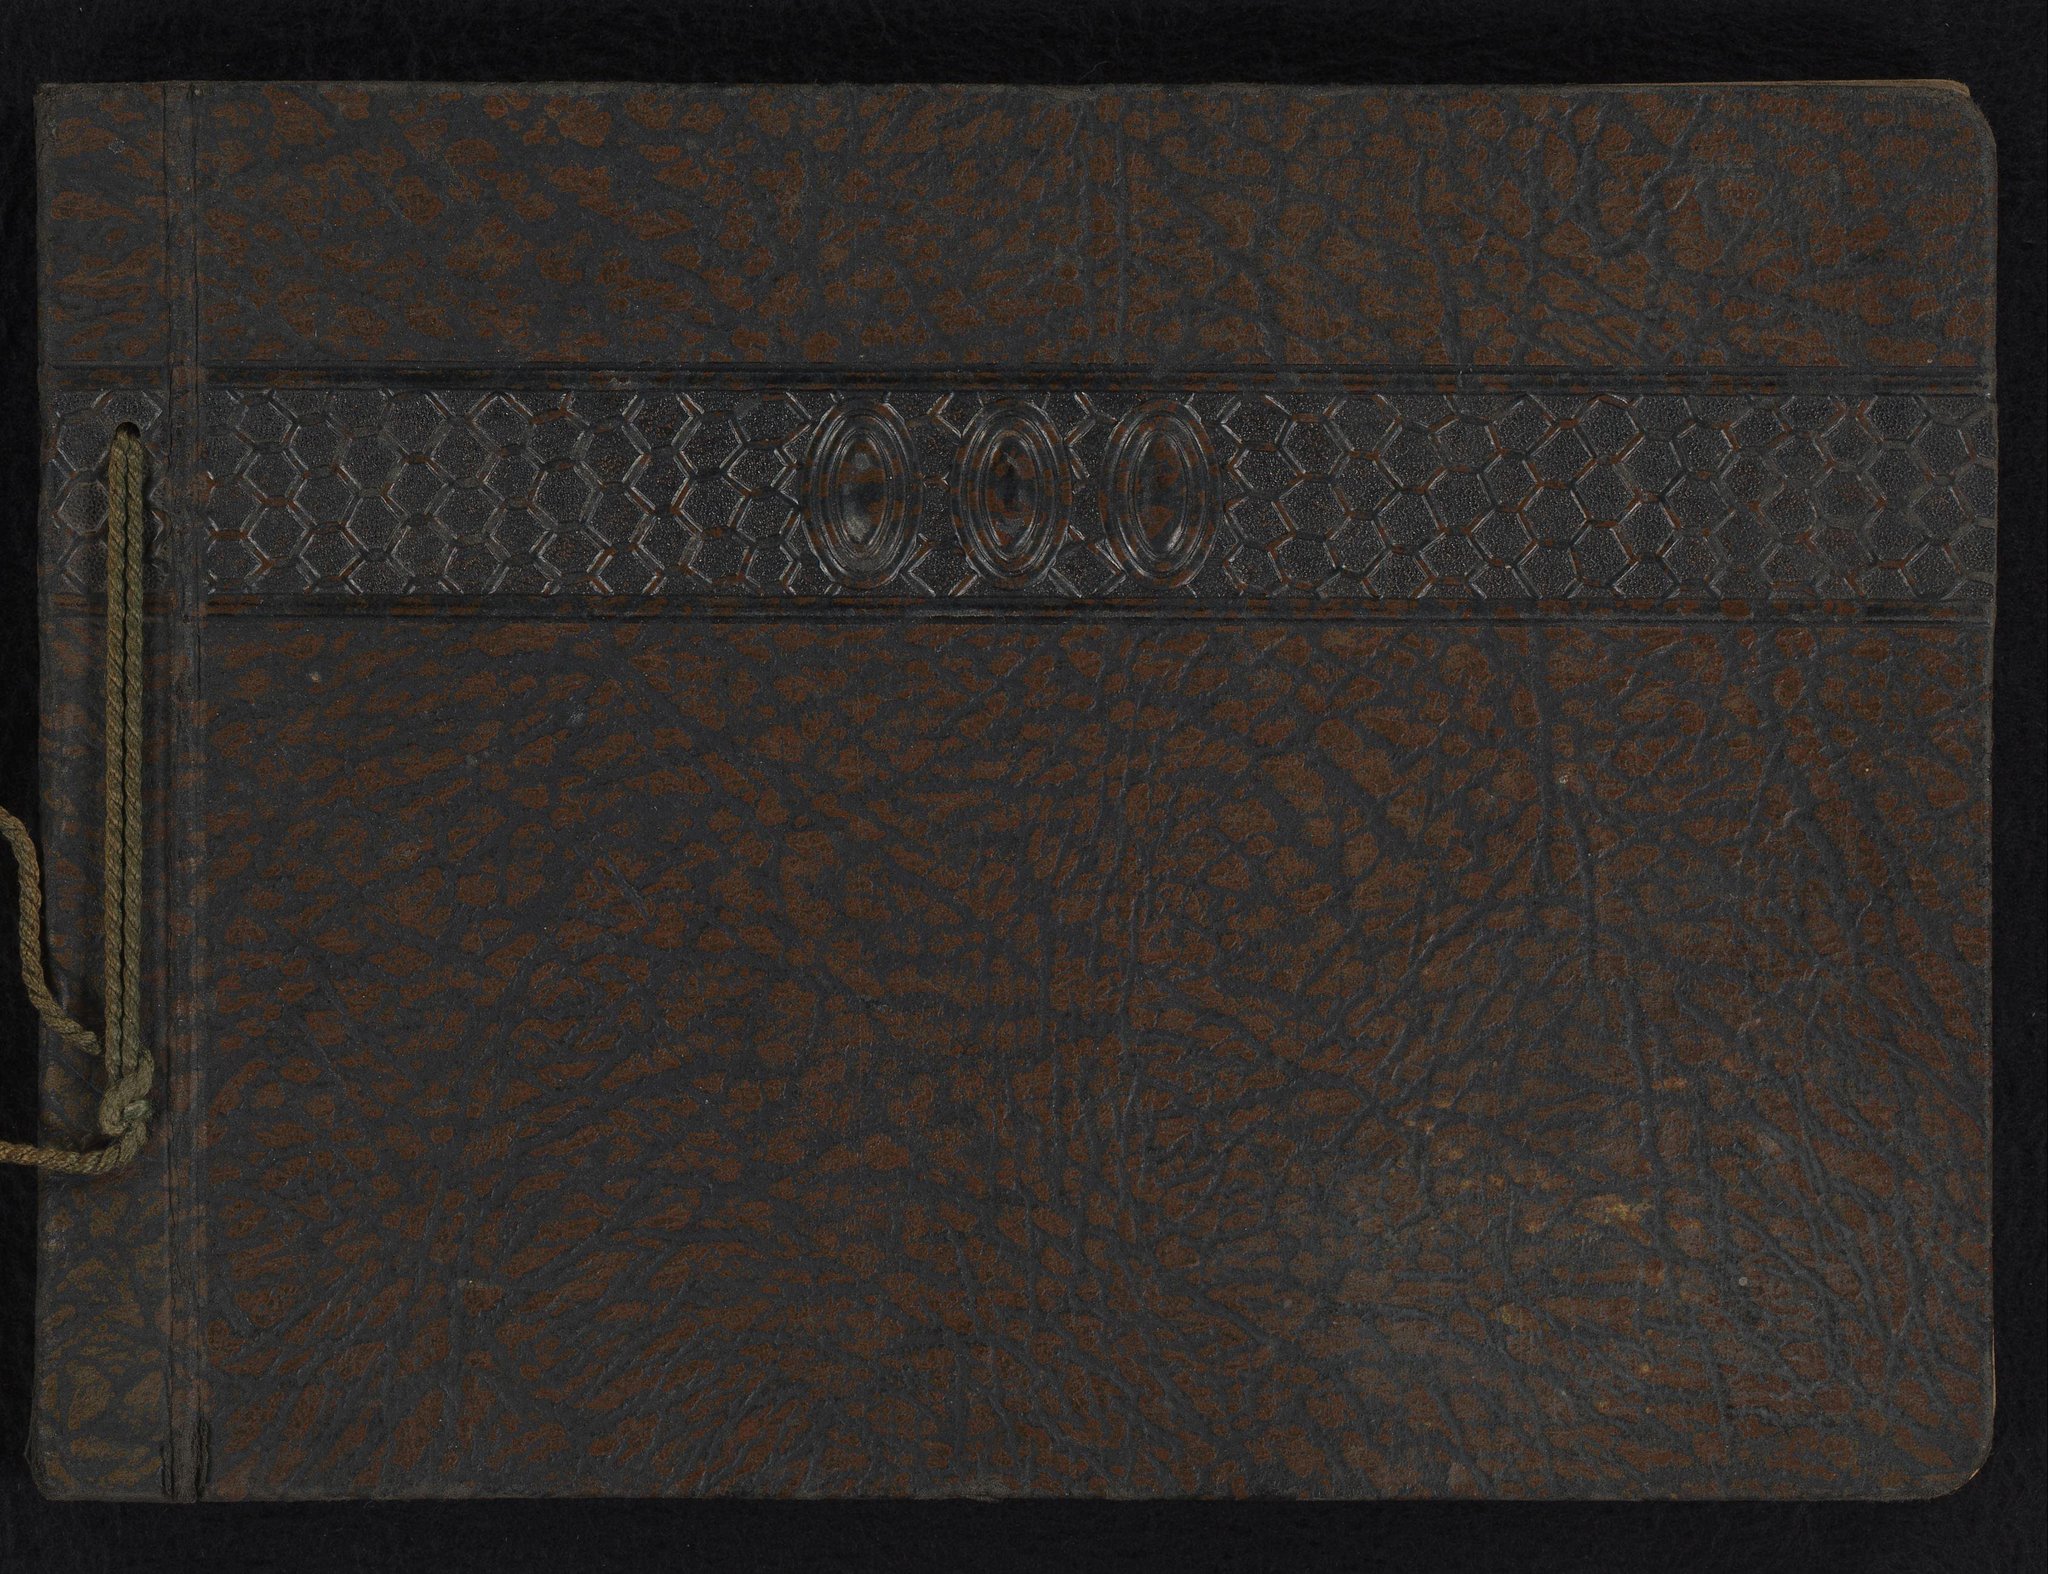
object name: scrapbook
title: Familiealbum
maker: Anonymous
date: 1900-1912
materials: cardboard, photographic support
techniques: gelatin silver print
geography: netherlands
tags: netherlands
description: Familiealbum uit de eerste helft van de 20ste eeuw. Centraal in het album staat een meisje, eerst een baby, aan het eind een kind van ca. 7 jaar oud. Het album is afkomstig uit de familie Van der Meer. Kaft is van karton met leerprint, touwtje door de rug. Het album bevat elf pagina's van bruin karton waarvan de laatste vier leeg zijn. Achterin een losse foto in een mapje. In totaal 34 foto's, nogal wat van de foto's zijn genomen aan het strand.